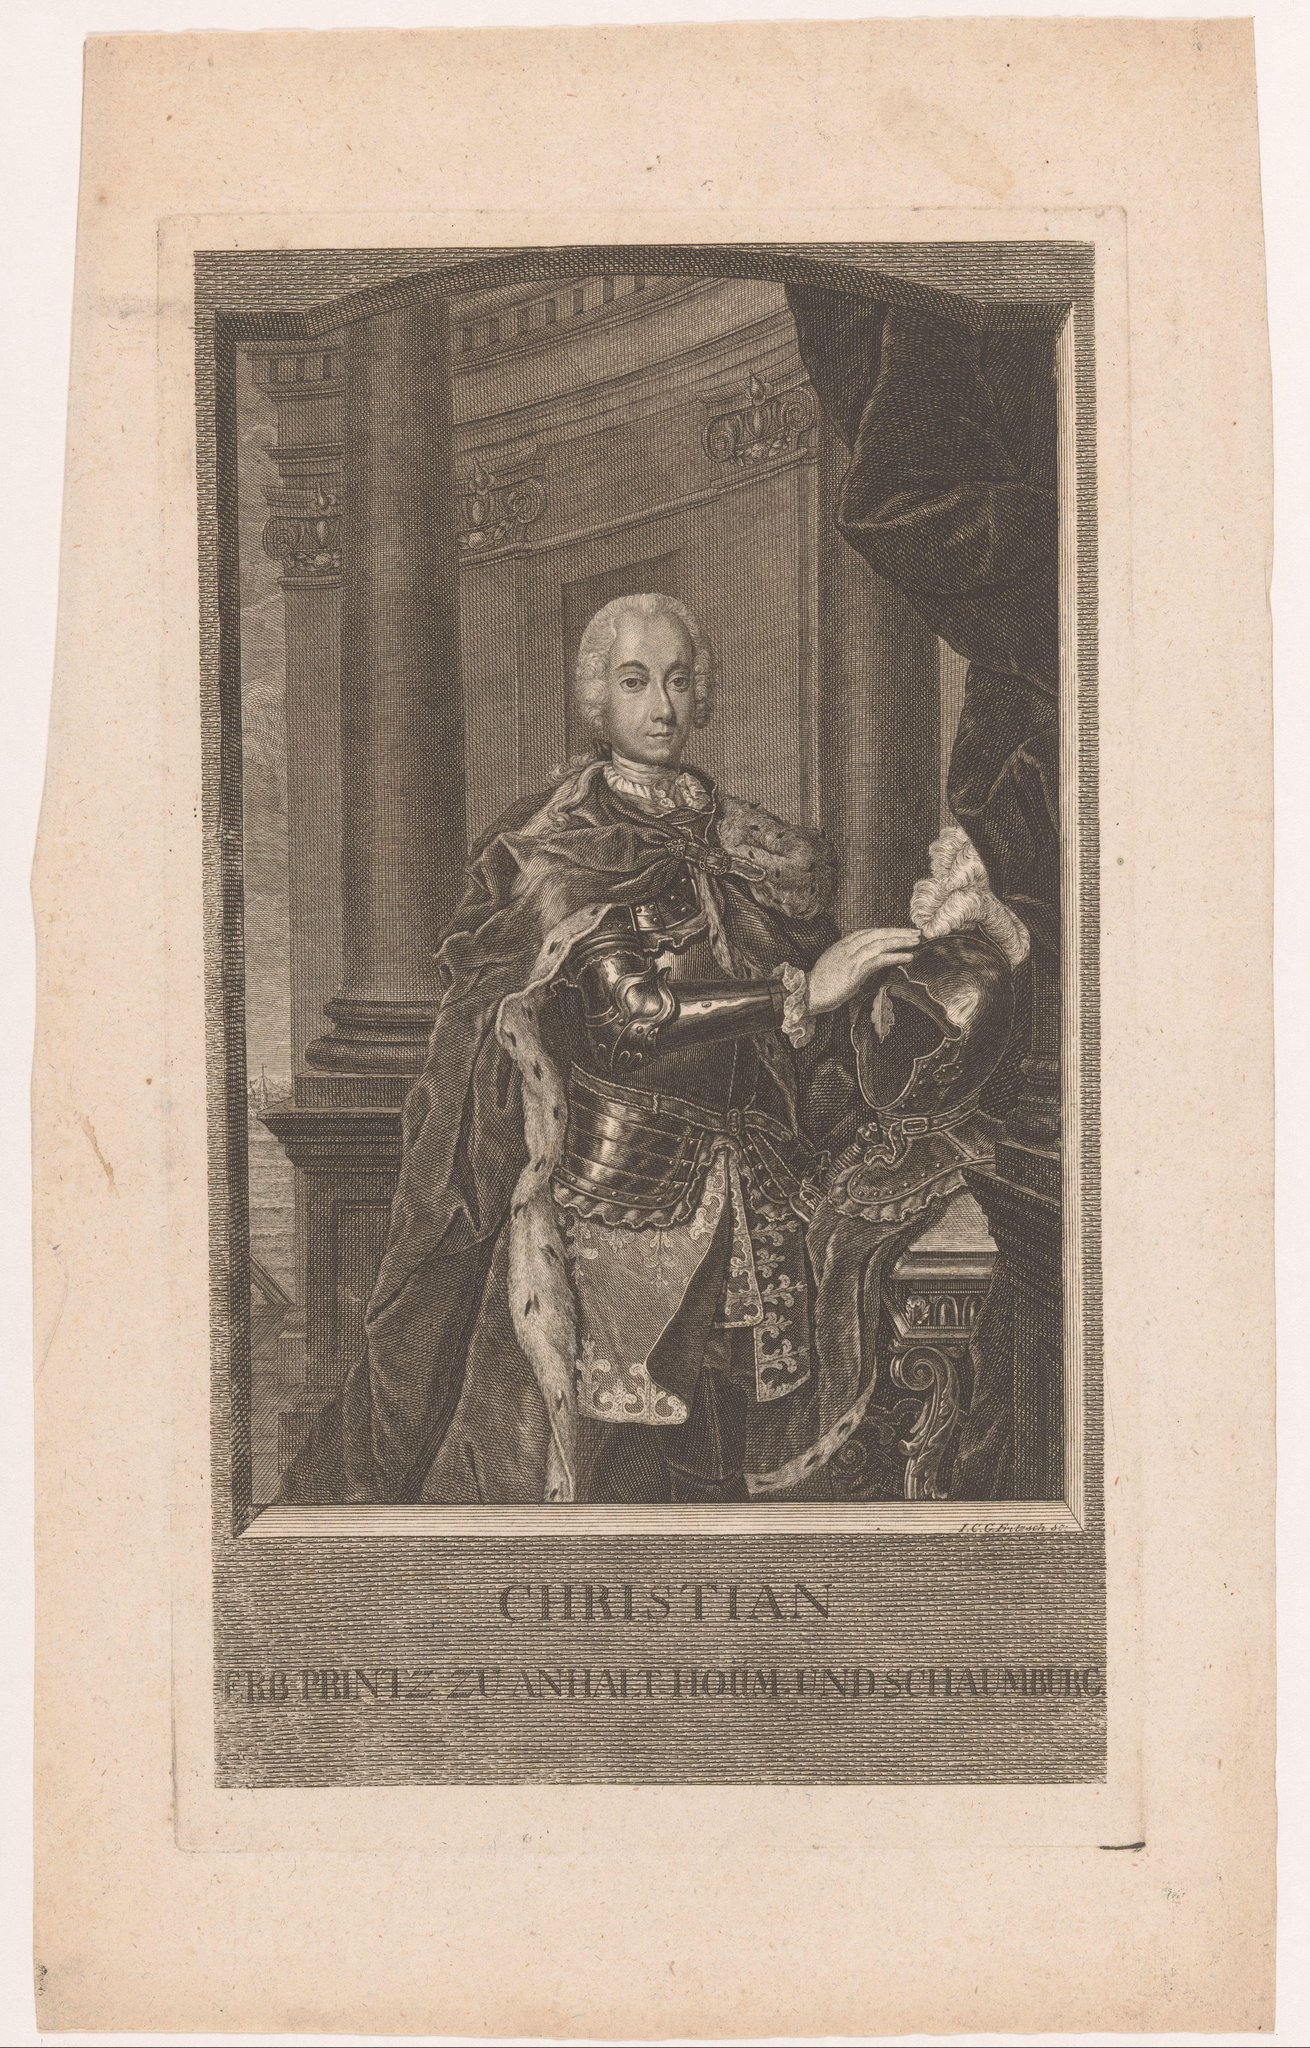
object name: print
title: Portret van Christian von Anhalt-Bernburg-Schaumburg-Hoym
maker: johann christian gottfried fritzsch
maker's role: print maker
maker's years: 1720-1802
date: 1730-1802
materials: paper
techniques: engraving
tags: helmet, armour, historical persons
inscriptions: collector's mark: Lugt 2228